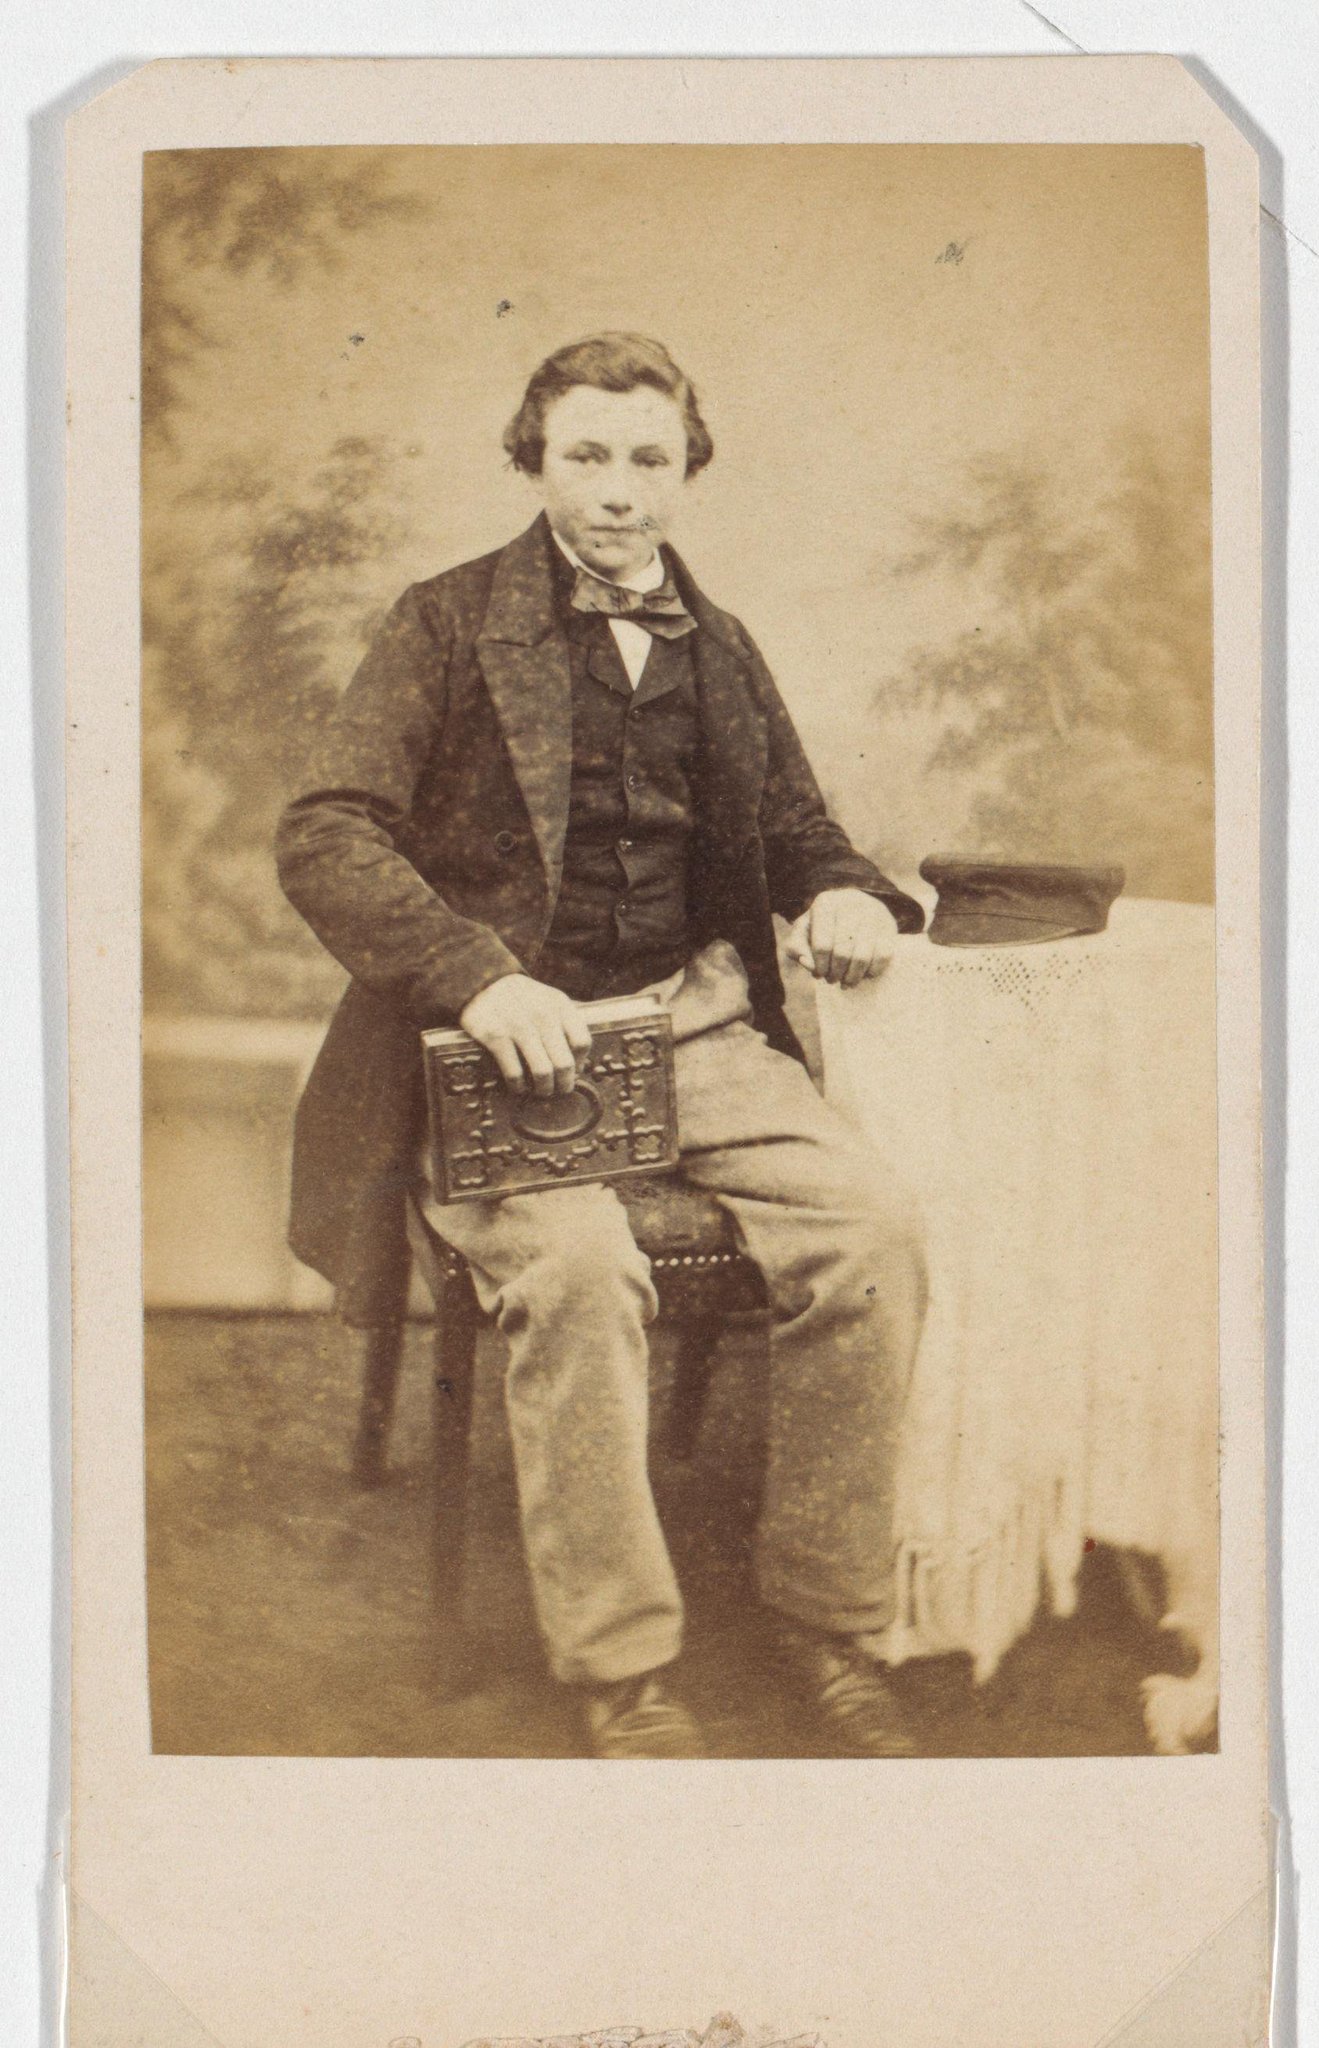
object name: carte de visite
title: Portret van een jongeman met een boek in de hand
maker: j. wijnman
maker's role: fotograaf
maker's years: 1844-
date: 1866-1870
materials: cardboard, paper, photographic support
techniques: albumen print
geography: amsterdam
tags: studio requisites ~ photographer, historical persons not known by name, amsterdam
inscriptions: address: ‘Halsteeg No. 248 Amsterdam’